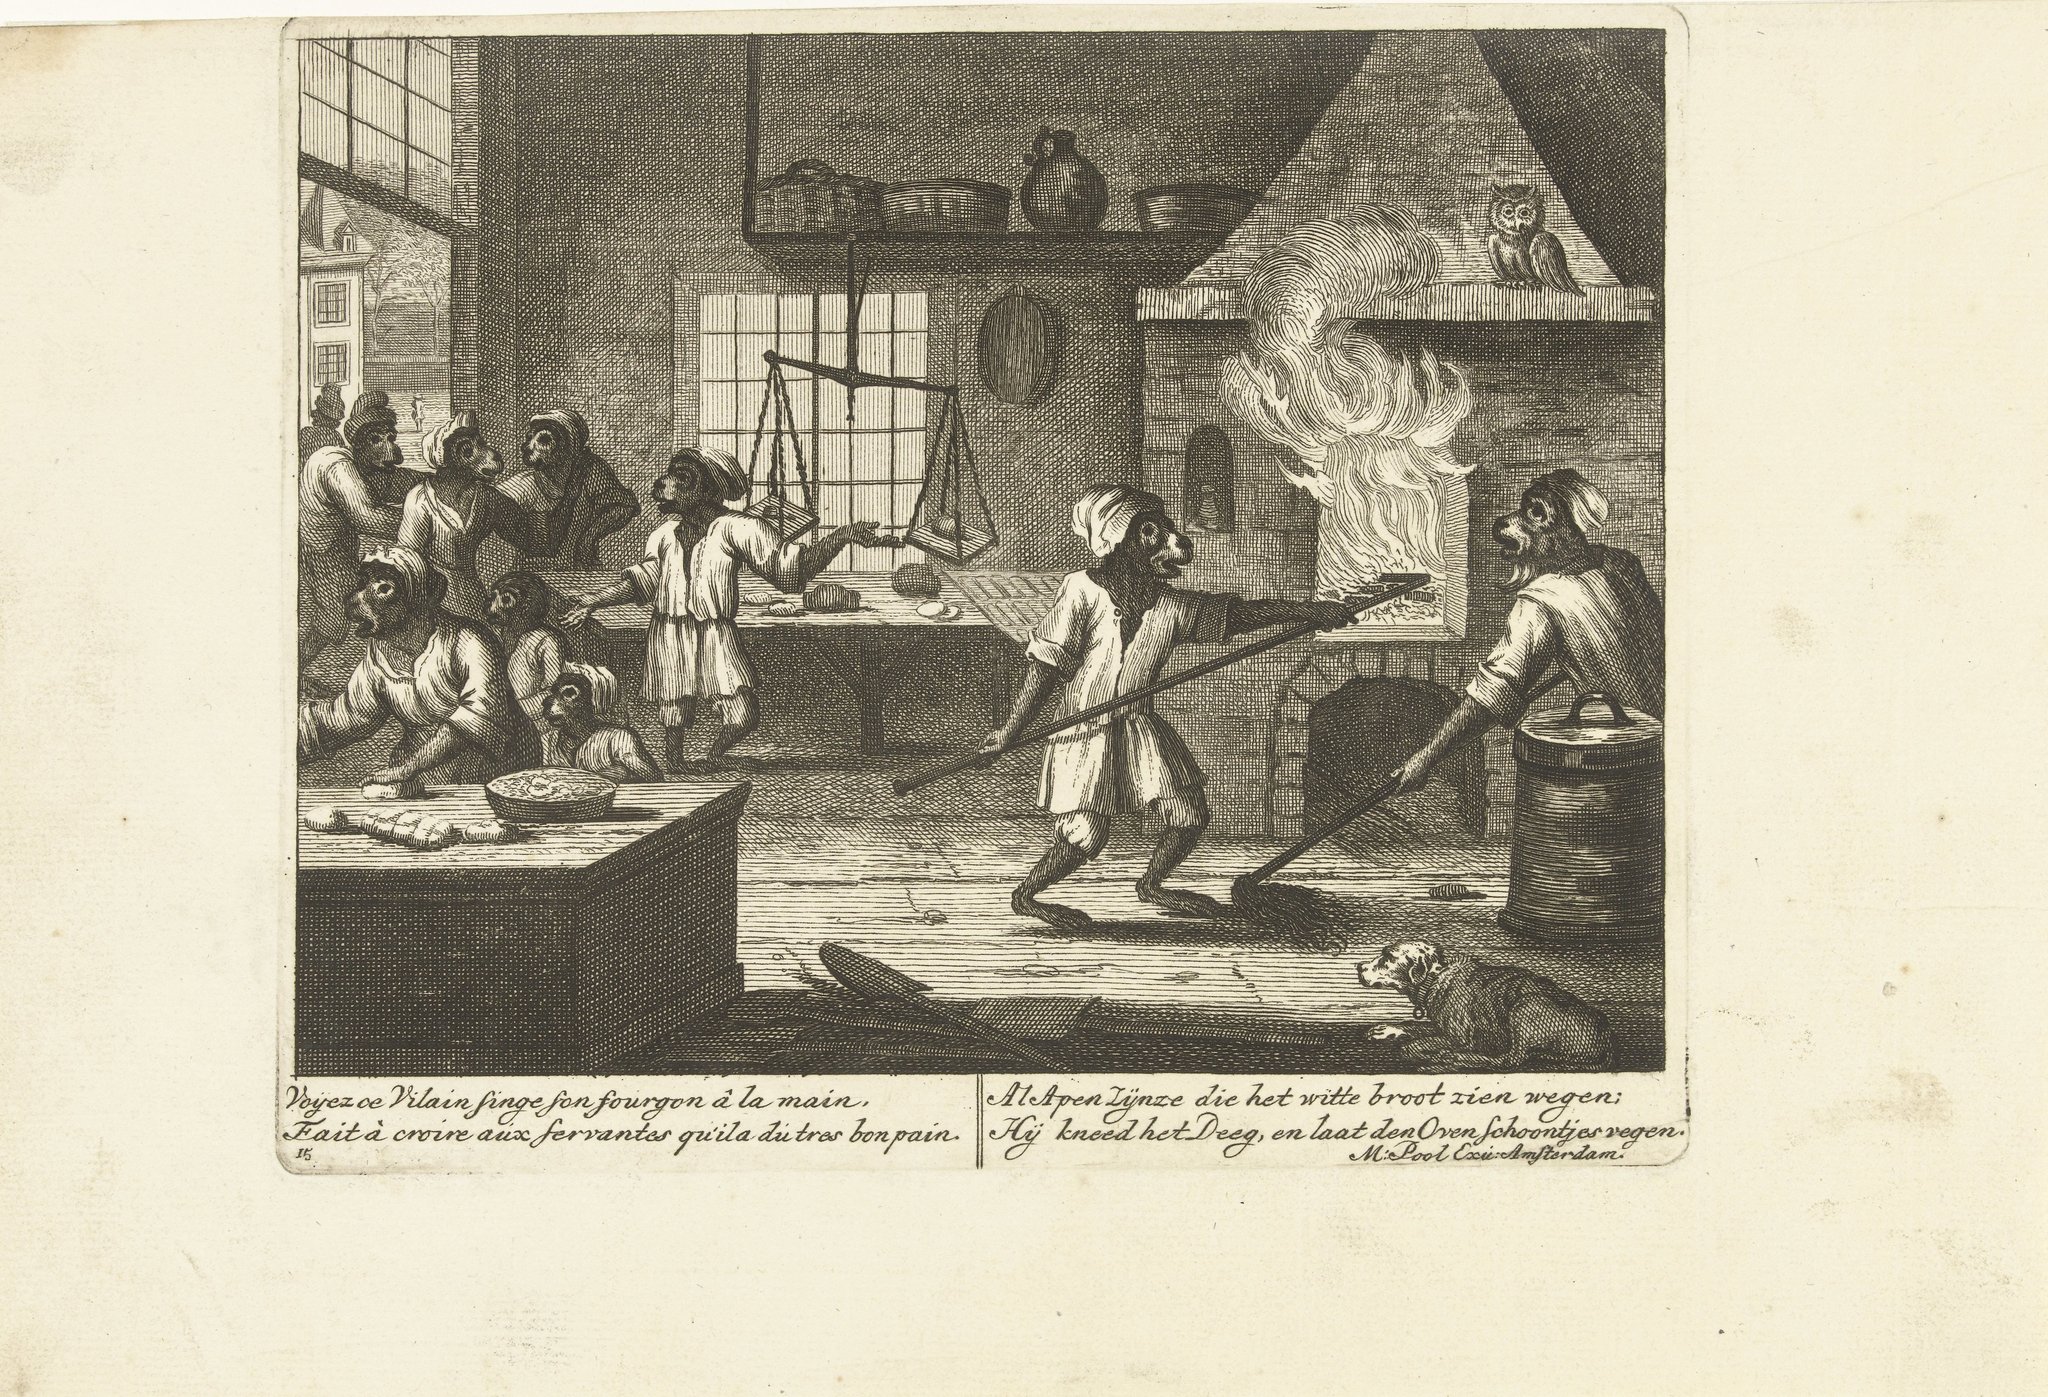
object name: print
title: Apenspel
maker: matthijs pool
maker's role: print maker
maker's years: 1676-1740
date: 1720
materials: paper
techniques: engraving, etching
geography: amsterdam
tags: monkeys, apes, animals acting as human beings, baker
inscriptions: collector's mark: Lugt 2228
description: Apen brood aan het bakken in een bakkerij. In het onderschrift versjes in het Frans en Nederlands. Prent nr. 15 in een serie van 16 prenten van ca. 1720 waarin apen als mensen figureren in allerlei huishoudelijke taferelen.